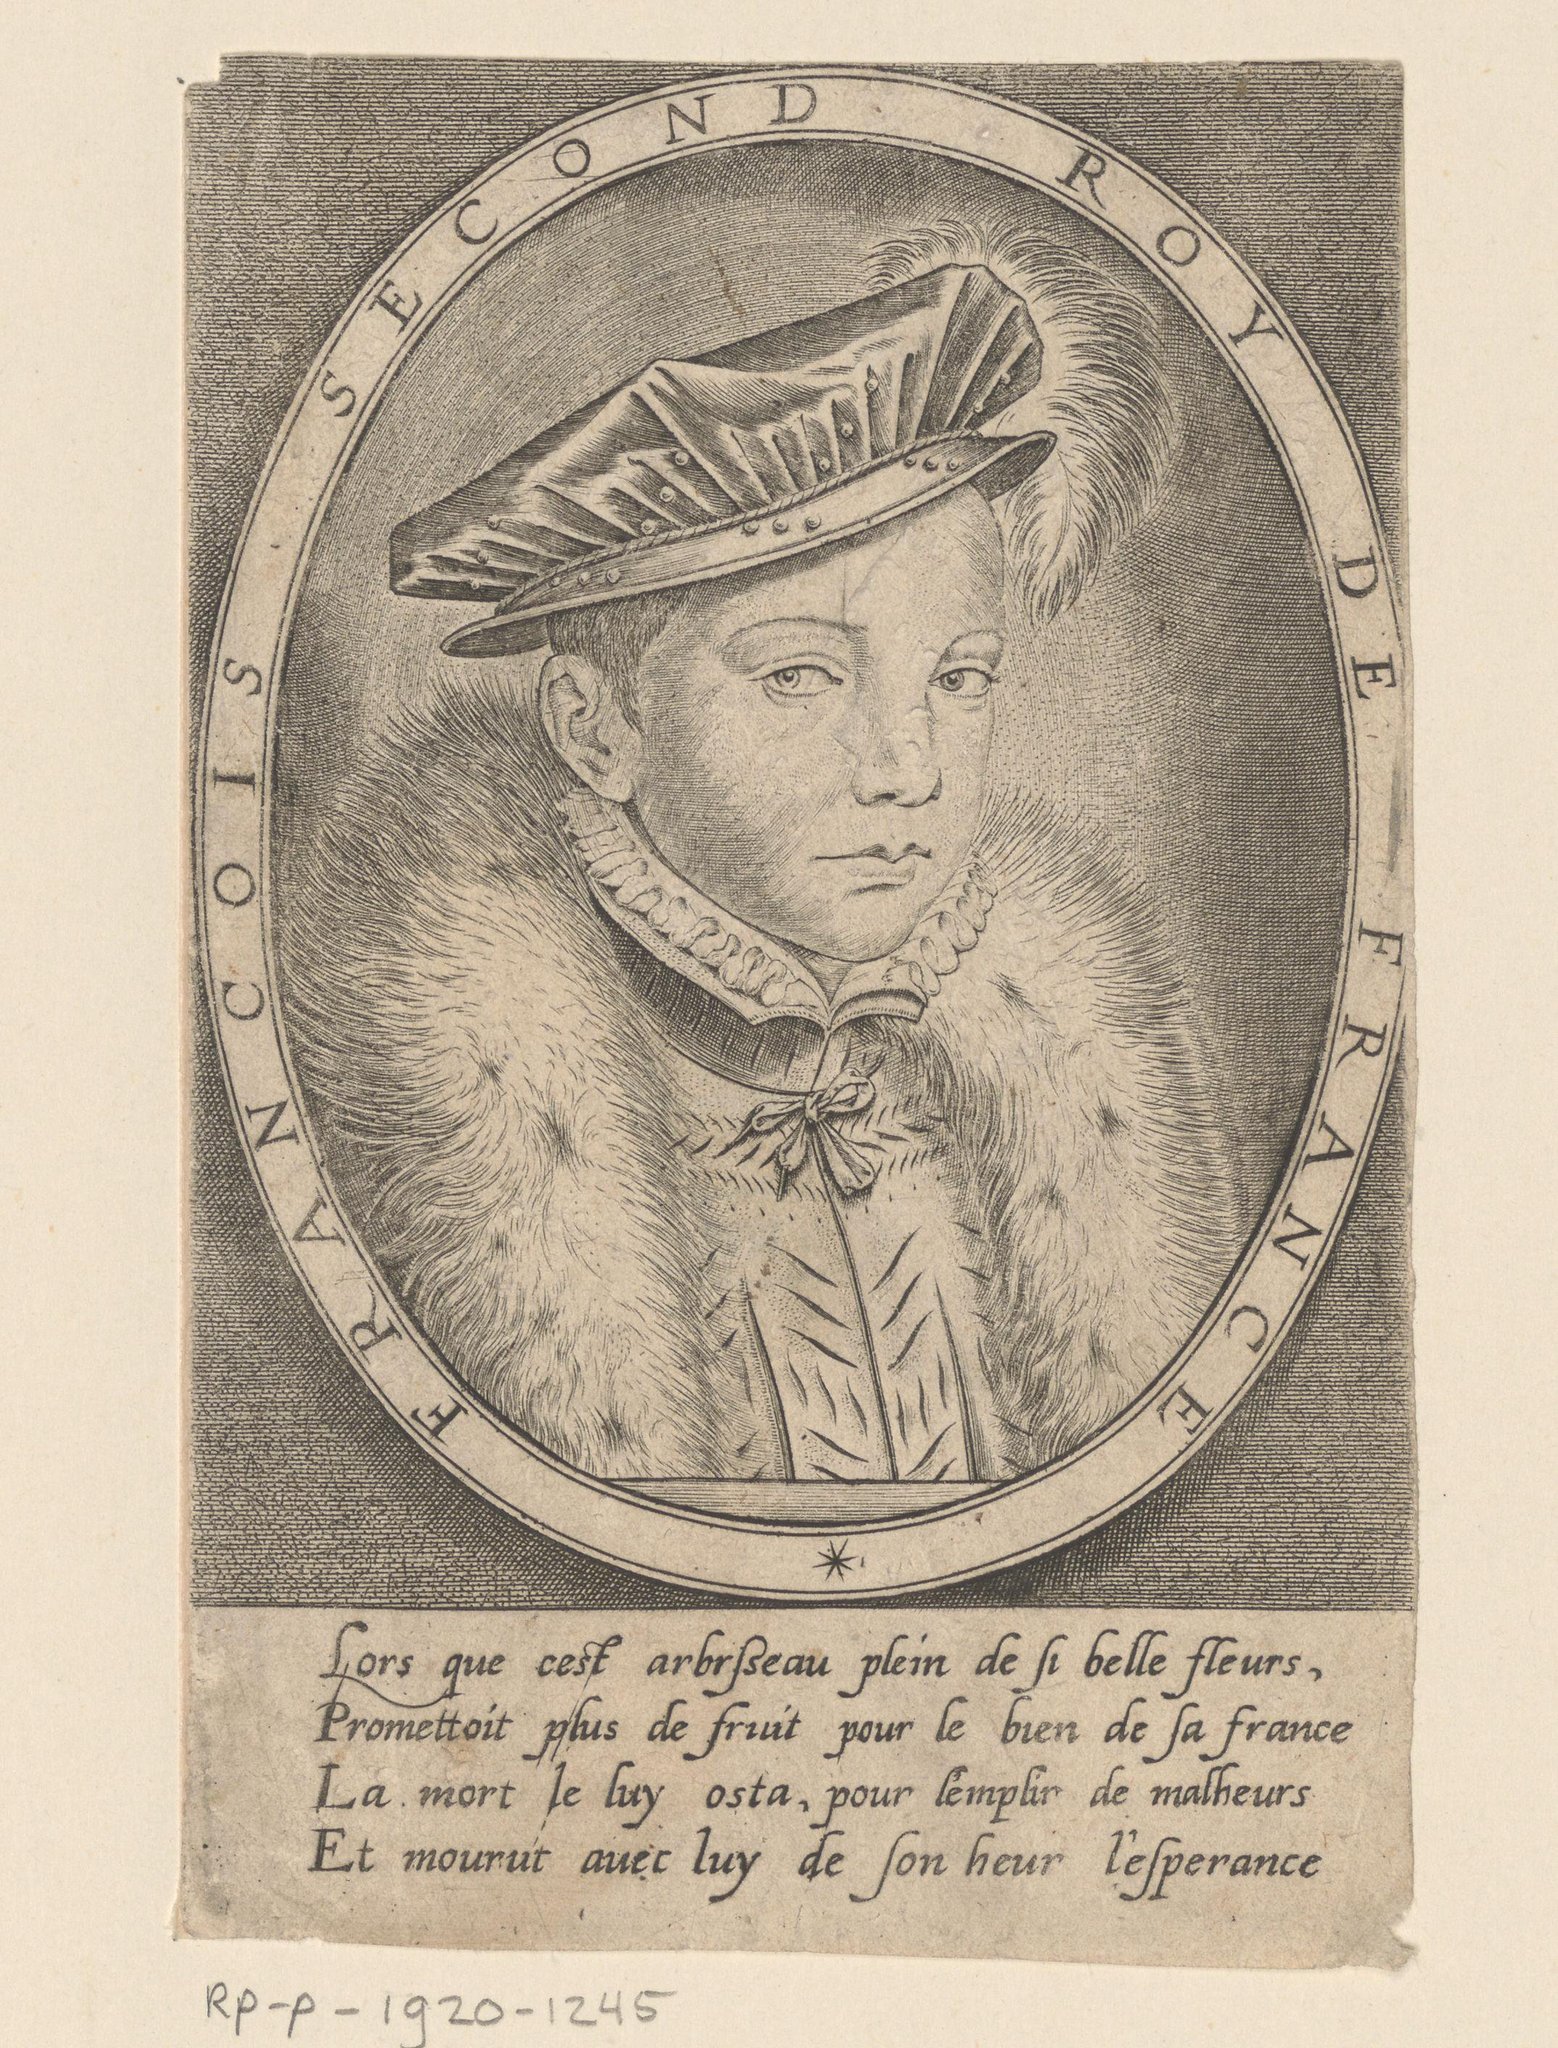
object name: print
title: Portret van Frans II van Frankrijk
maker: thomas de leu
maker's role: print maker, publisher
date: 1576-1614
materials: paper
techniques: engraving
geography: france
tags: paris, historical persons, king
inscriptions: collector's mark: Lugt 2228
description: Met vierregelig vers in het Frans onder het portret.